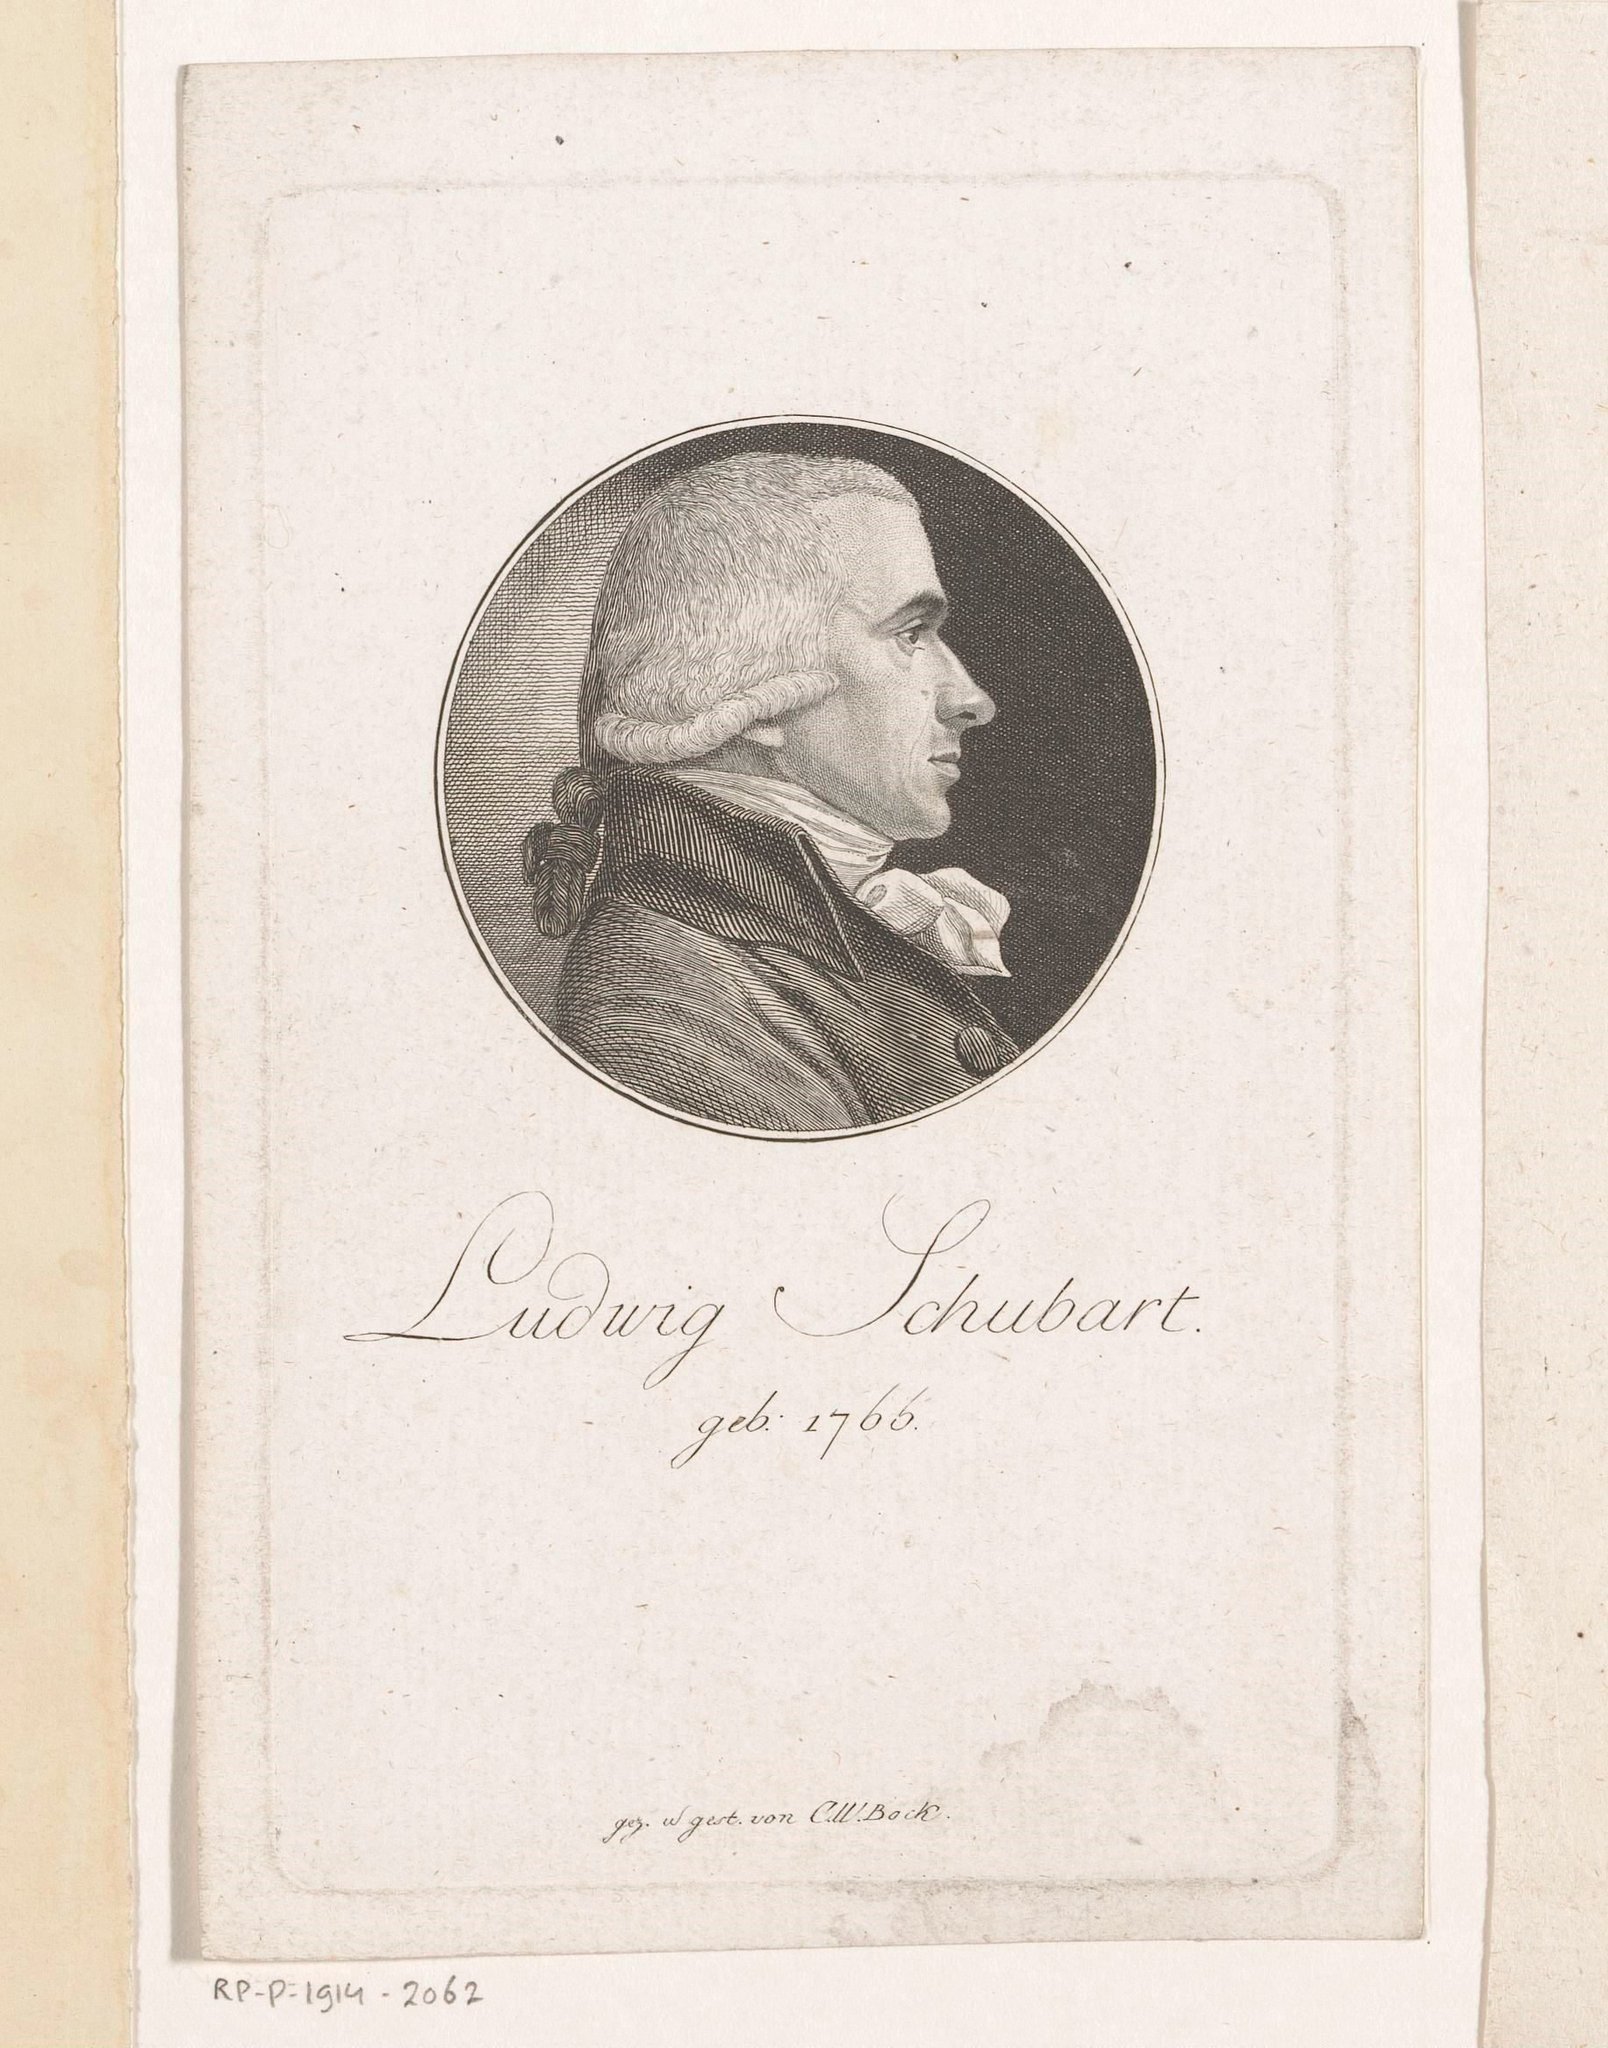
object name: print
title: Portret van Ludwig Schubart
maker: christoph wilhelm bock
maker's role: print maker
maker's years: 1755-1836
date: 1780-1820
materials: paper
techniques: engraving, etching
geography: nuremberg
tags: historical persons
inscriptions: collector's mark: Lugt 2228